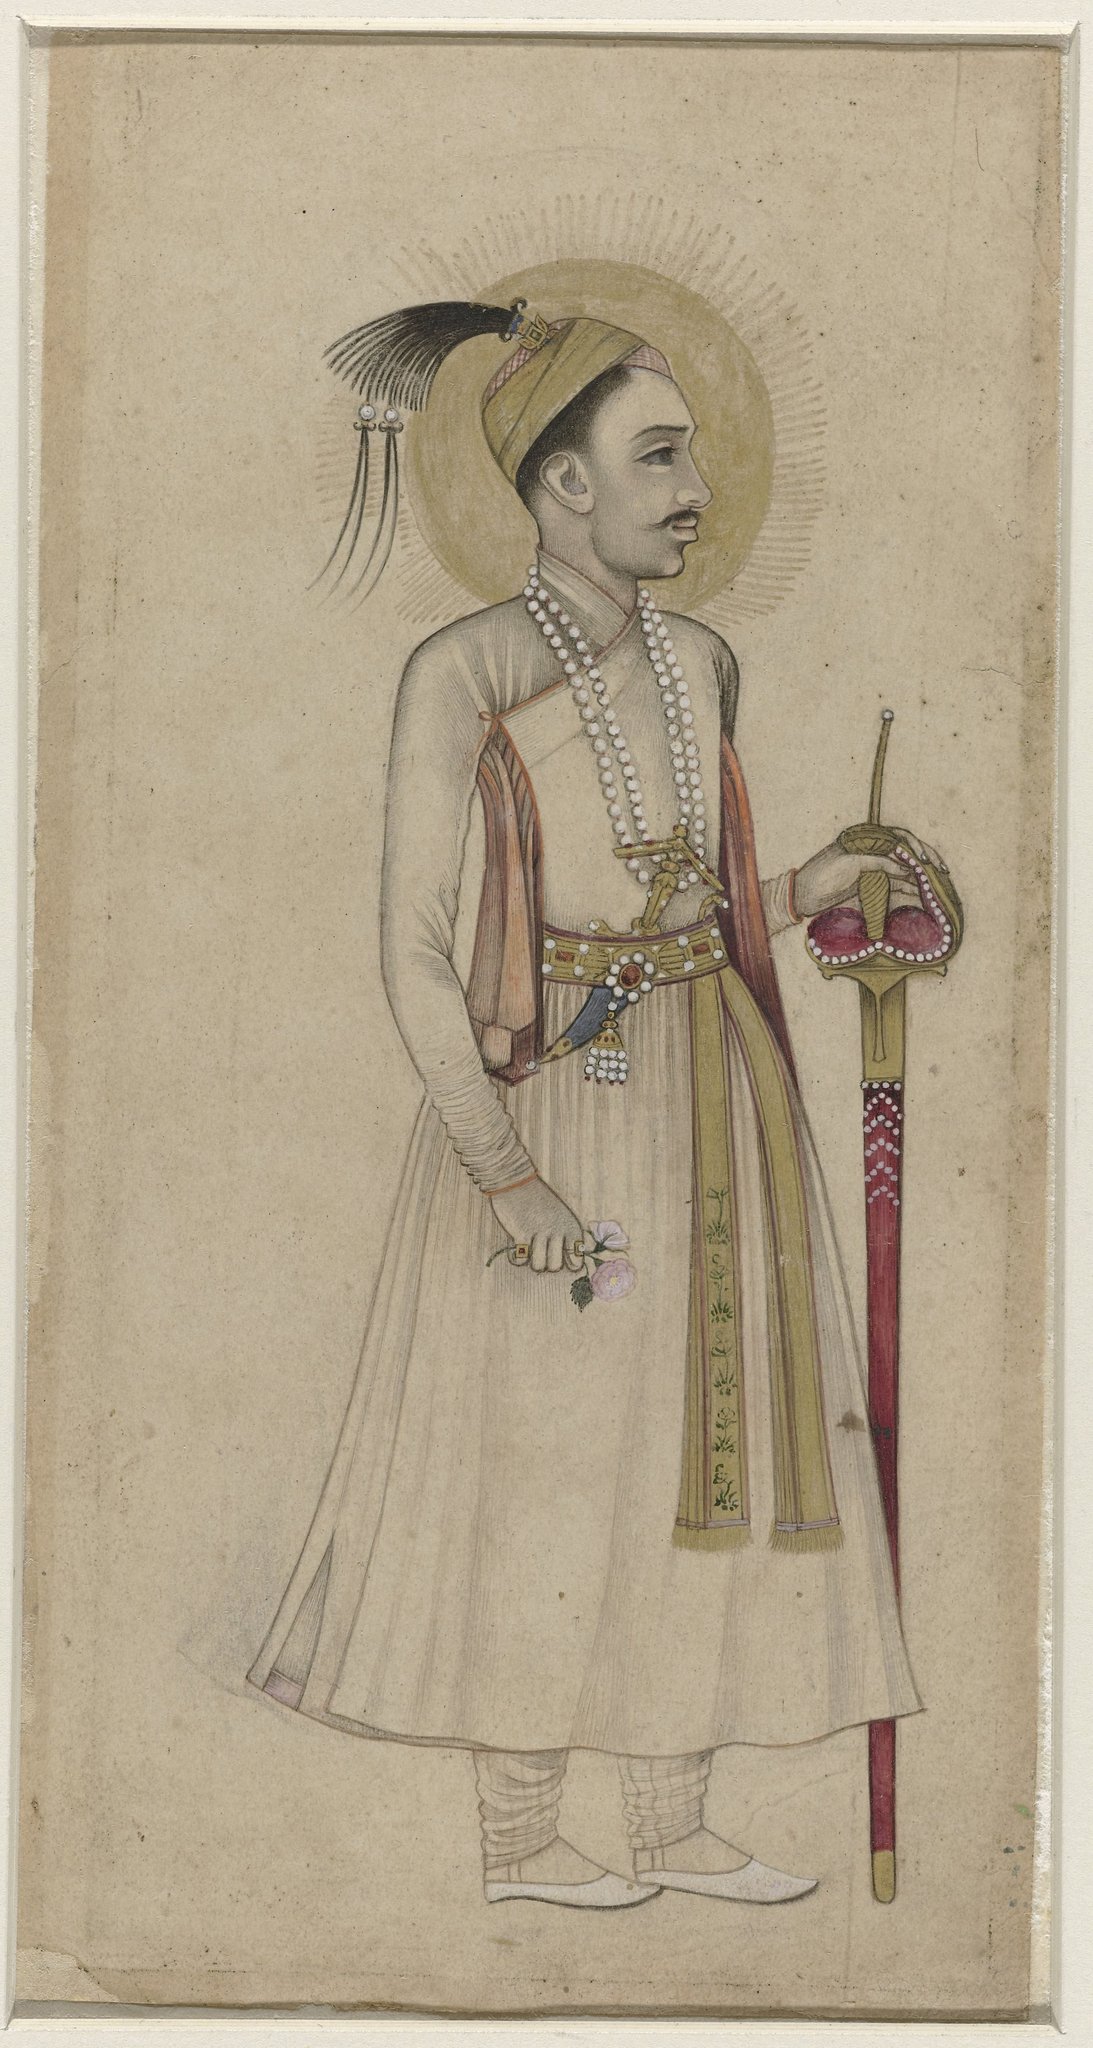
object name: indian miniature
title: Portret van Sultan Muhammad-Quli Qutb-Shah van Golconda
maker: Anonymous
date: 1630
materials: paint, paper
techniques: brush